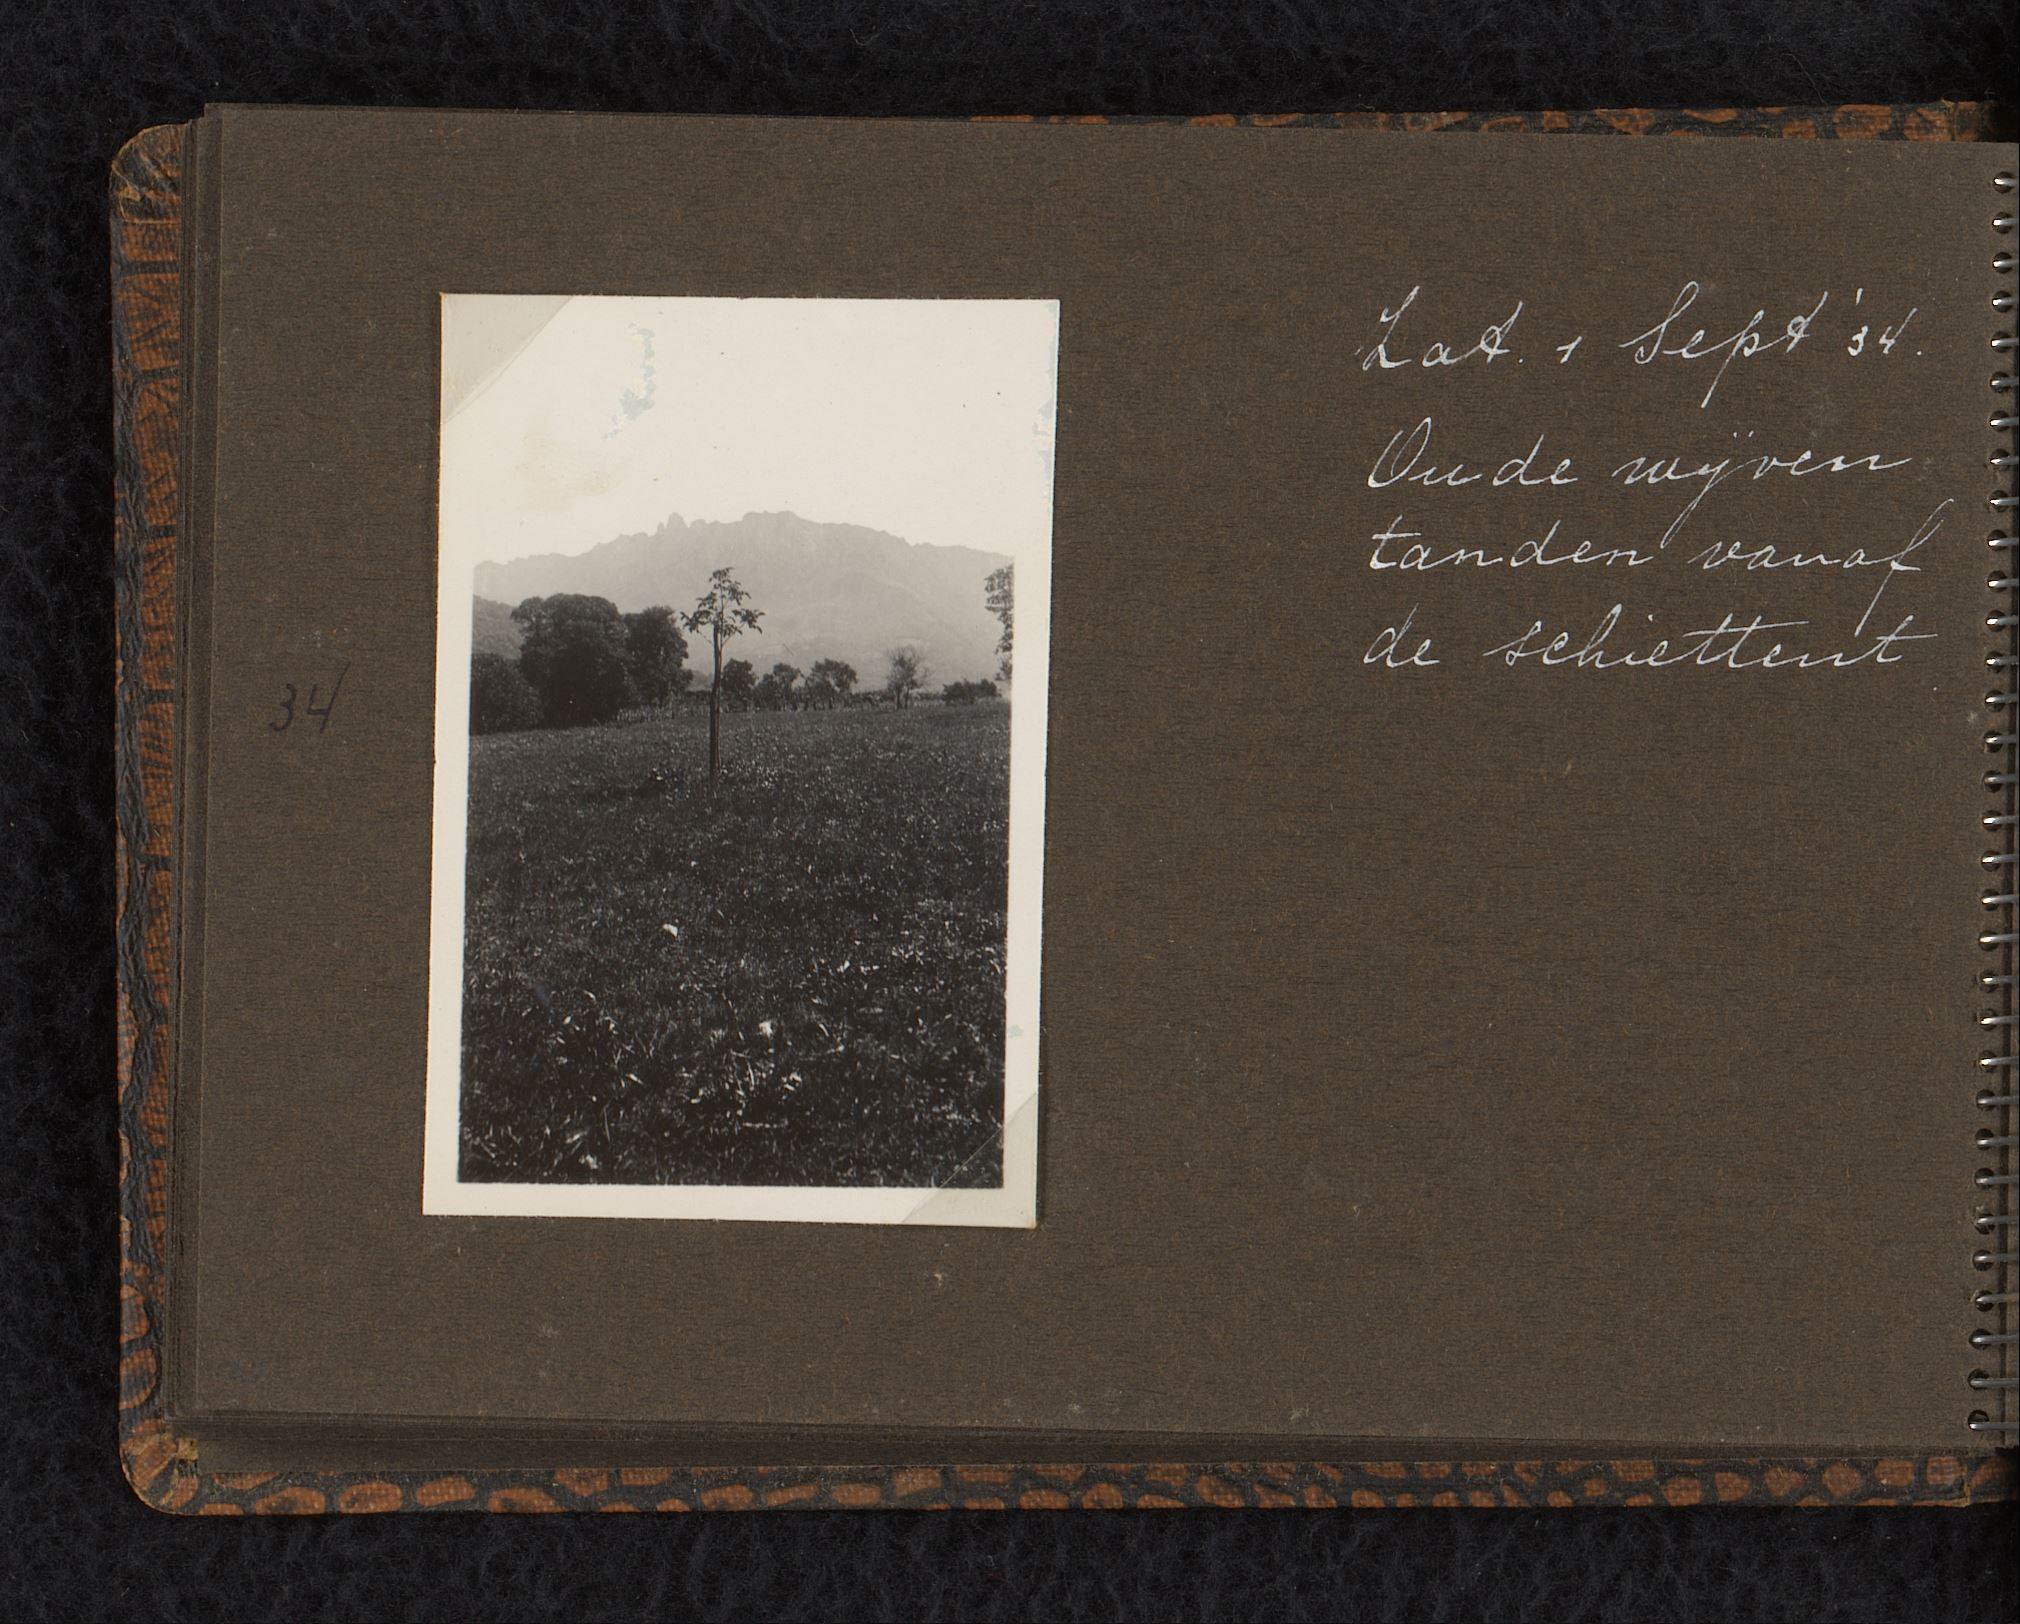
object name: album leaf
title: Gezicht op een weide en de Denti della Vecchia, Ticino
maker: Anonymous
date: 1934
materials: paper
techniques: gelatin silver print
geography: ticino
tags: mountain meadow, alp, mountains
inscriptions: number: ‘34’